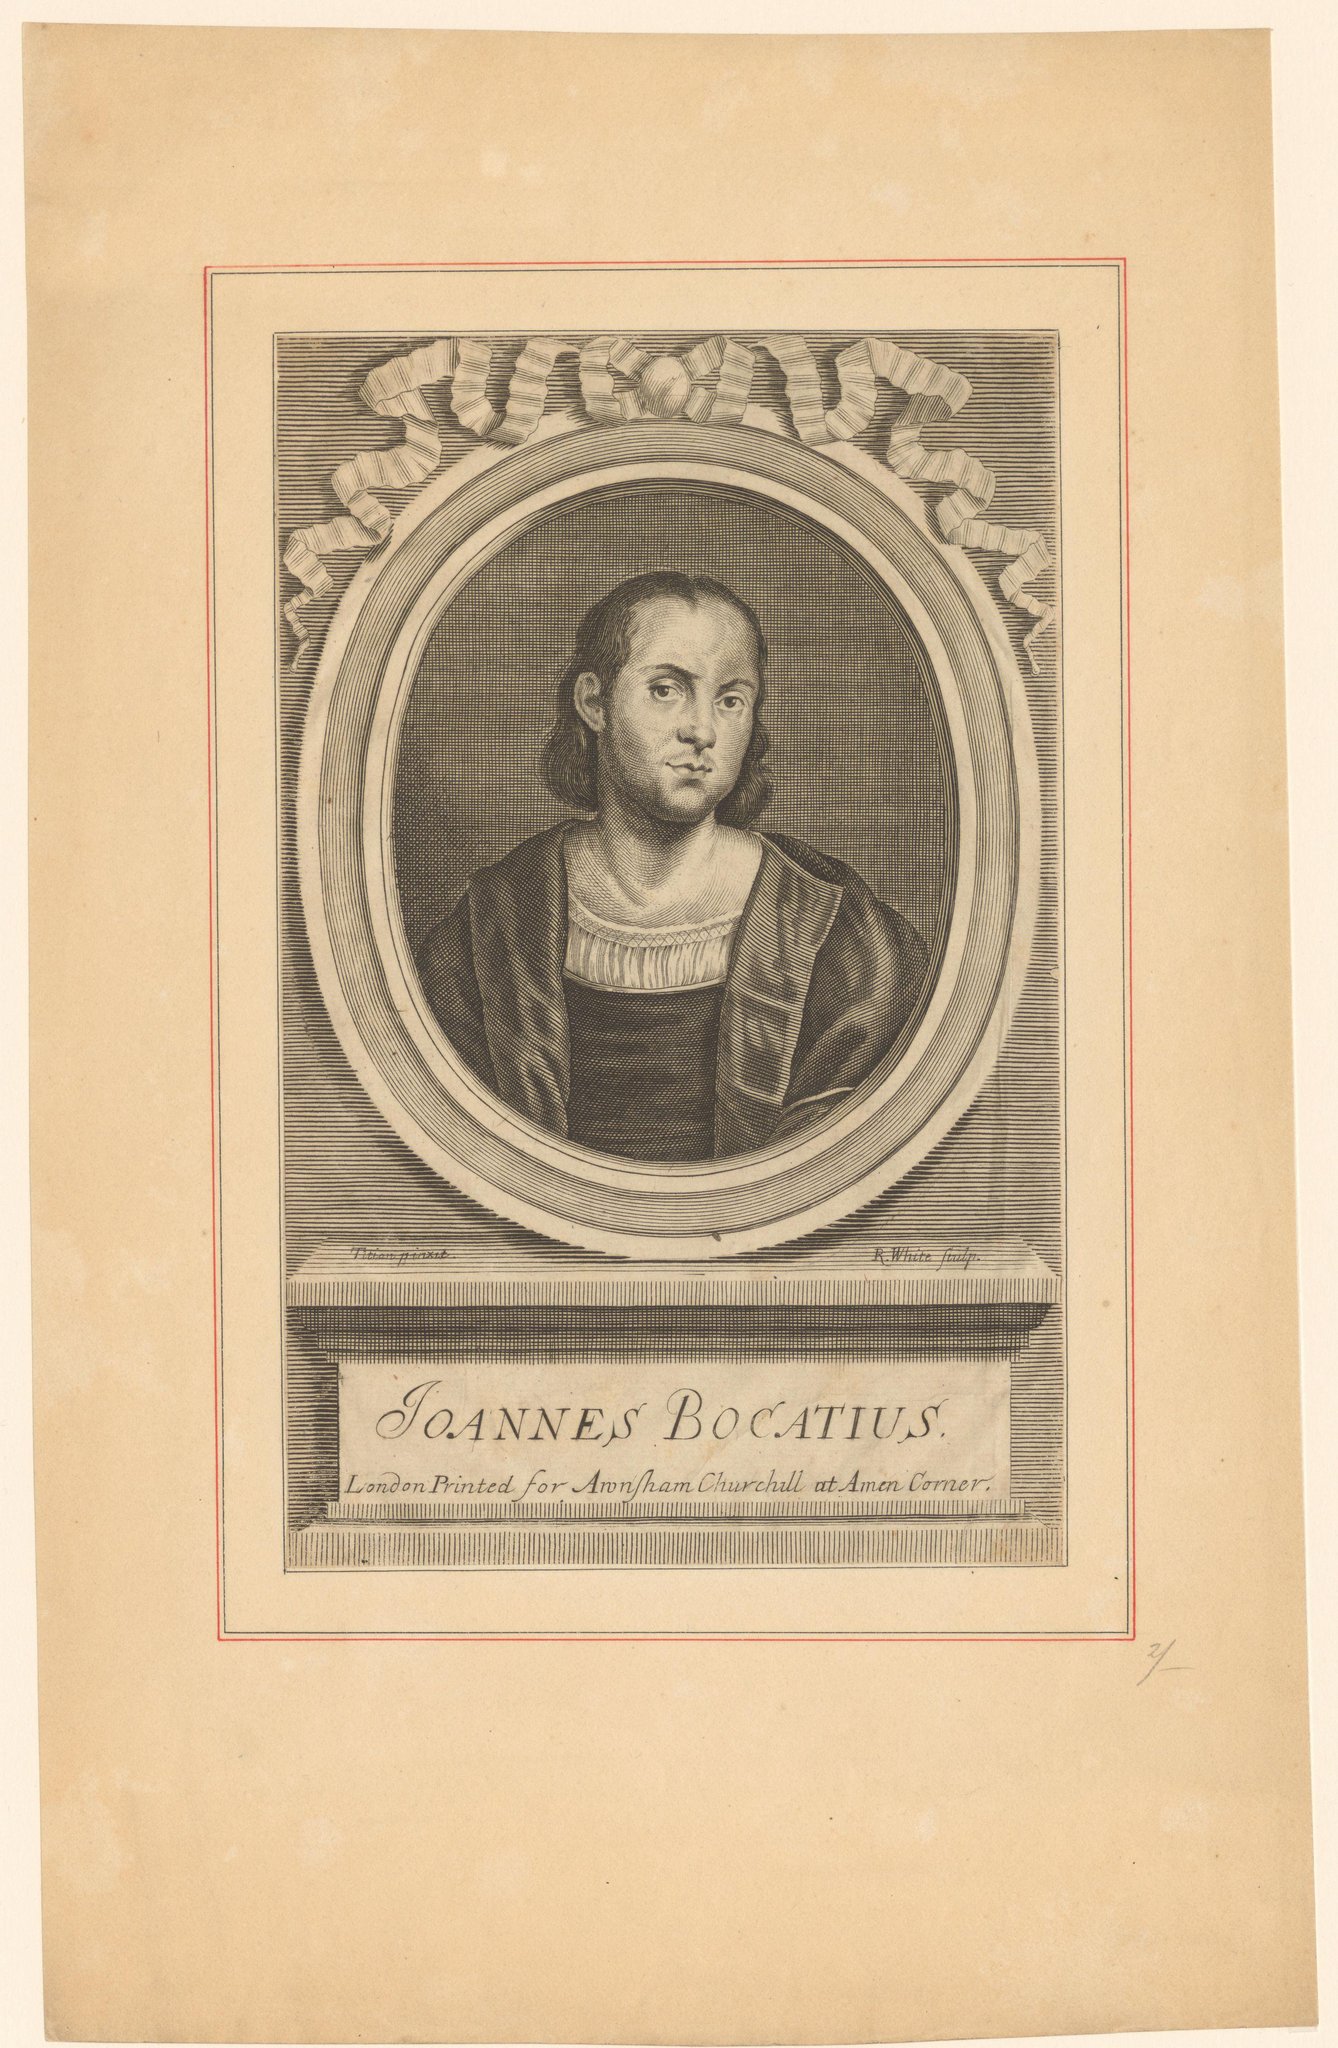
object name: book illustration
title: Joannes Bocatius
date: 1684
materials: paper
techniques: engraving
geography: london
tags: giovanni boccaccio, historical persons not known by name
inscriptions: collector's mark: Lugt 2228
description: Het portret is niet van Giovanni Boccaccio, en mogelijk is het schilderij waar deze prent naar is ook niet van Titiaan. Prent uit: The Novels and Tales of the Renowned John Boccacio. Londen: Awnsham Churchill, 1684.